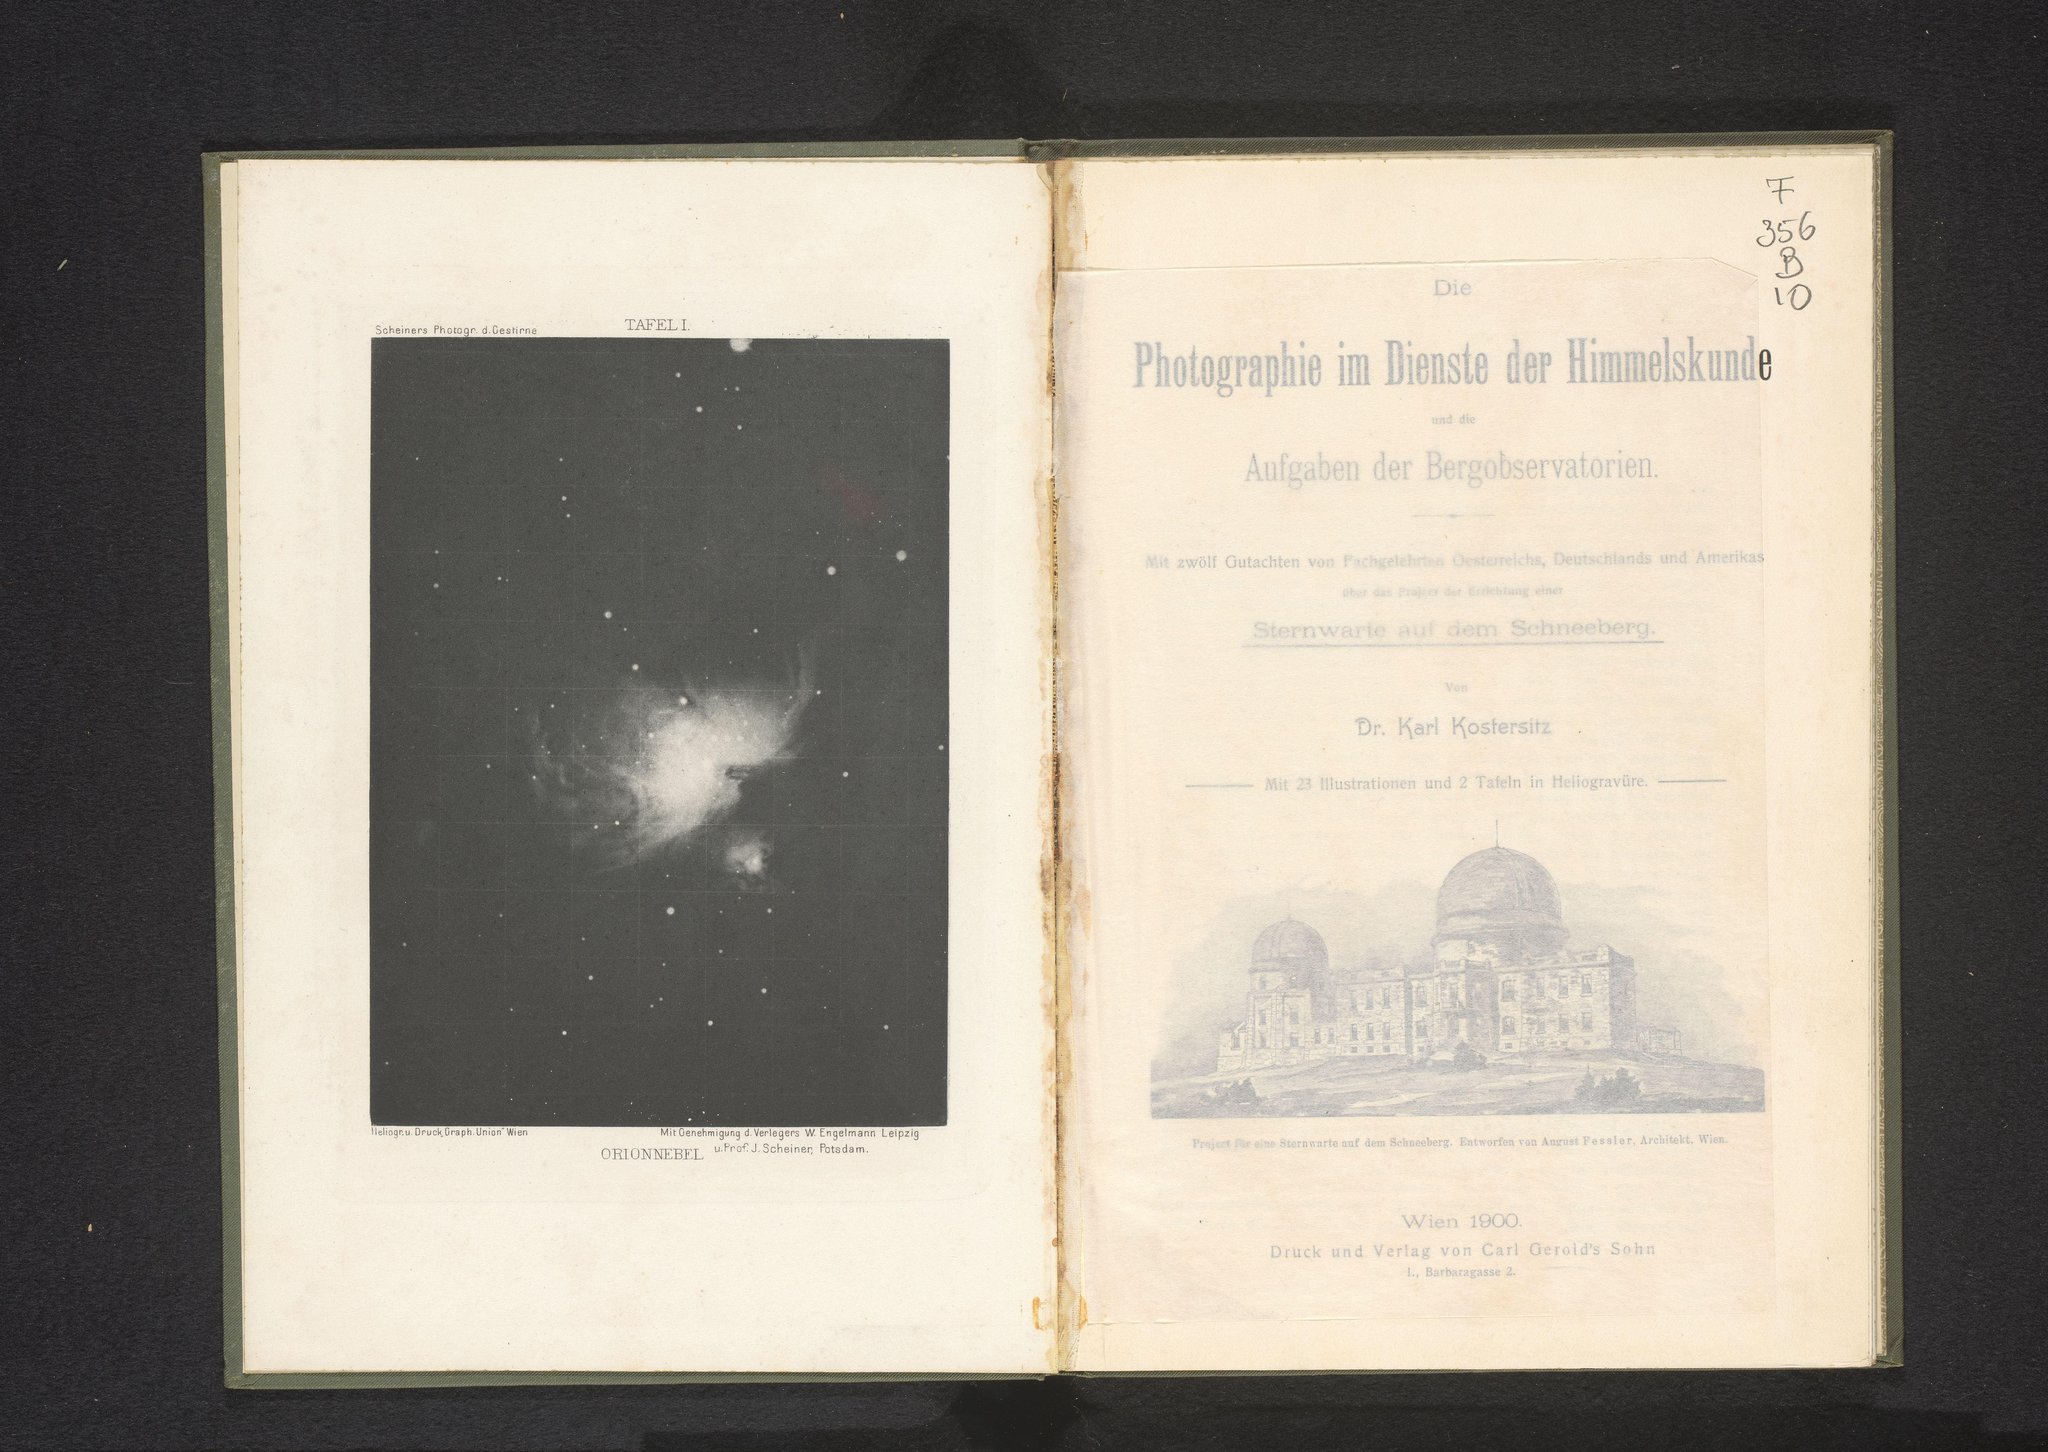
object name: photomechanical print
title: Orionnevel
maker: julius scheiner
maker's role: astronoom, fotograaf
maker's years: 1858-1913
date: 1870-1897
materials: paper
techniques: photoaquatint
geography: vienna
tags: stars and constellations: orion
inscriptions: name: ‘Scheiners Photogr. d. Gestirne Mit Genehmiging d. Verlegers. W. Engelmann Leipzig u. Prof. J. Scheiner, Potsdam.’, number: ‘Tafel 1.’